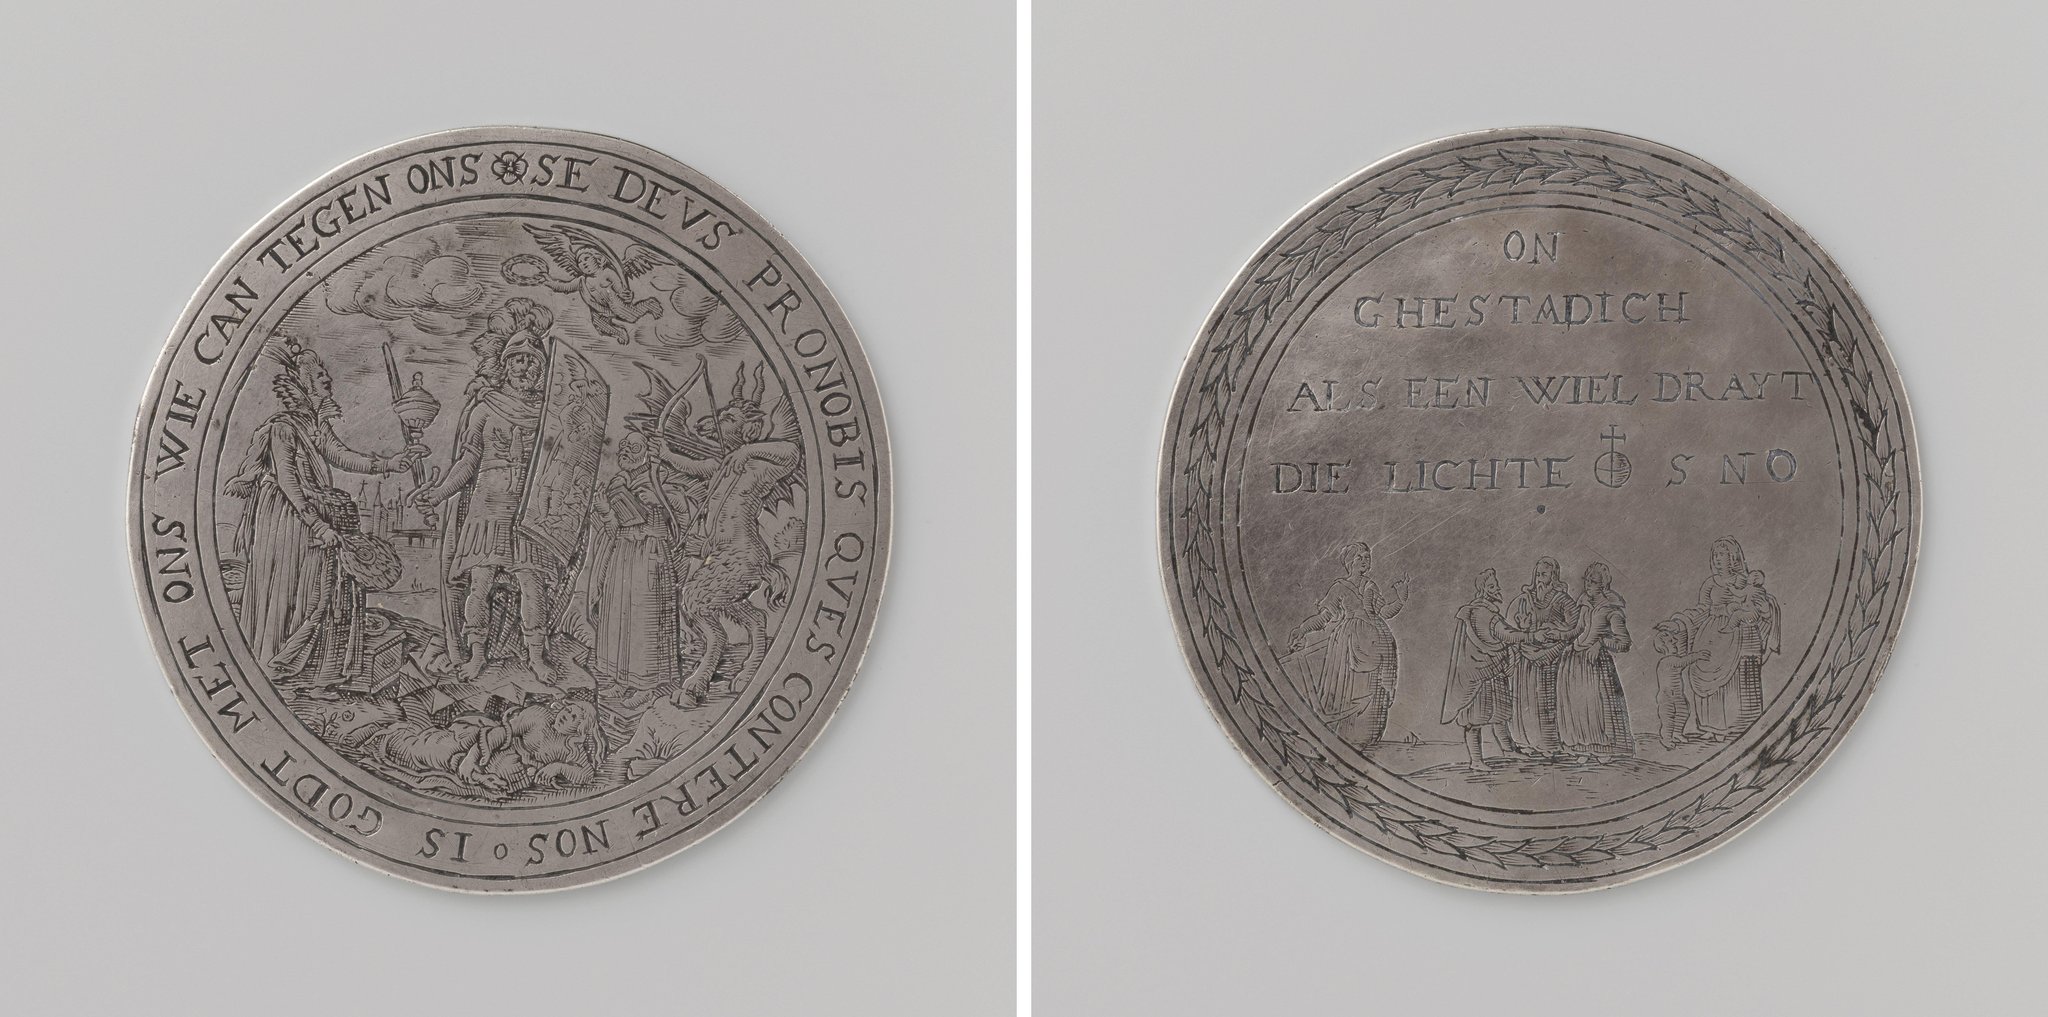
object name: family medal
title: Het huwelijk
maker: Anonymous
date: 1600-1699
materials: silver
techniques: engraving